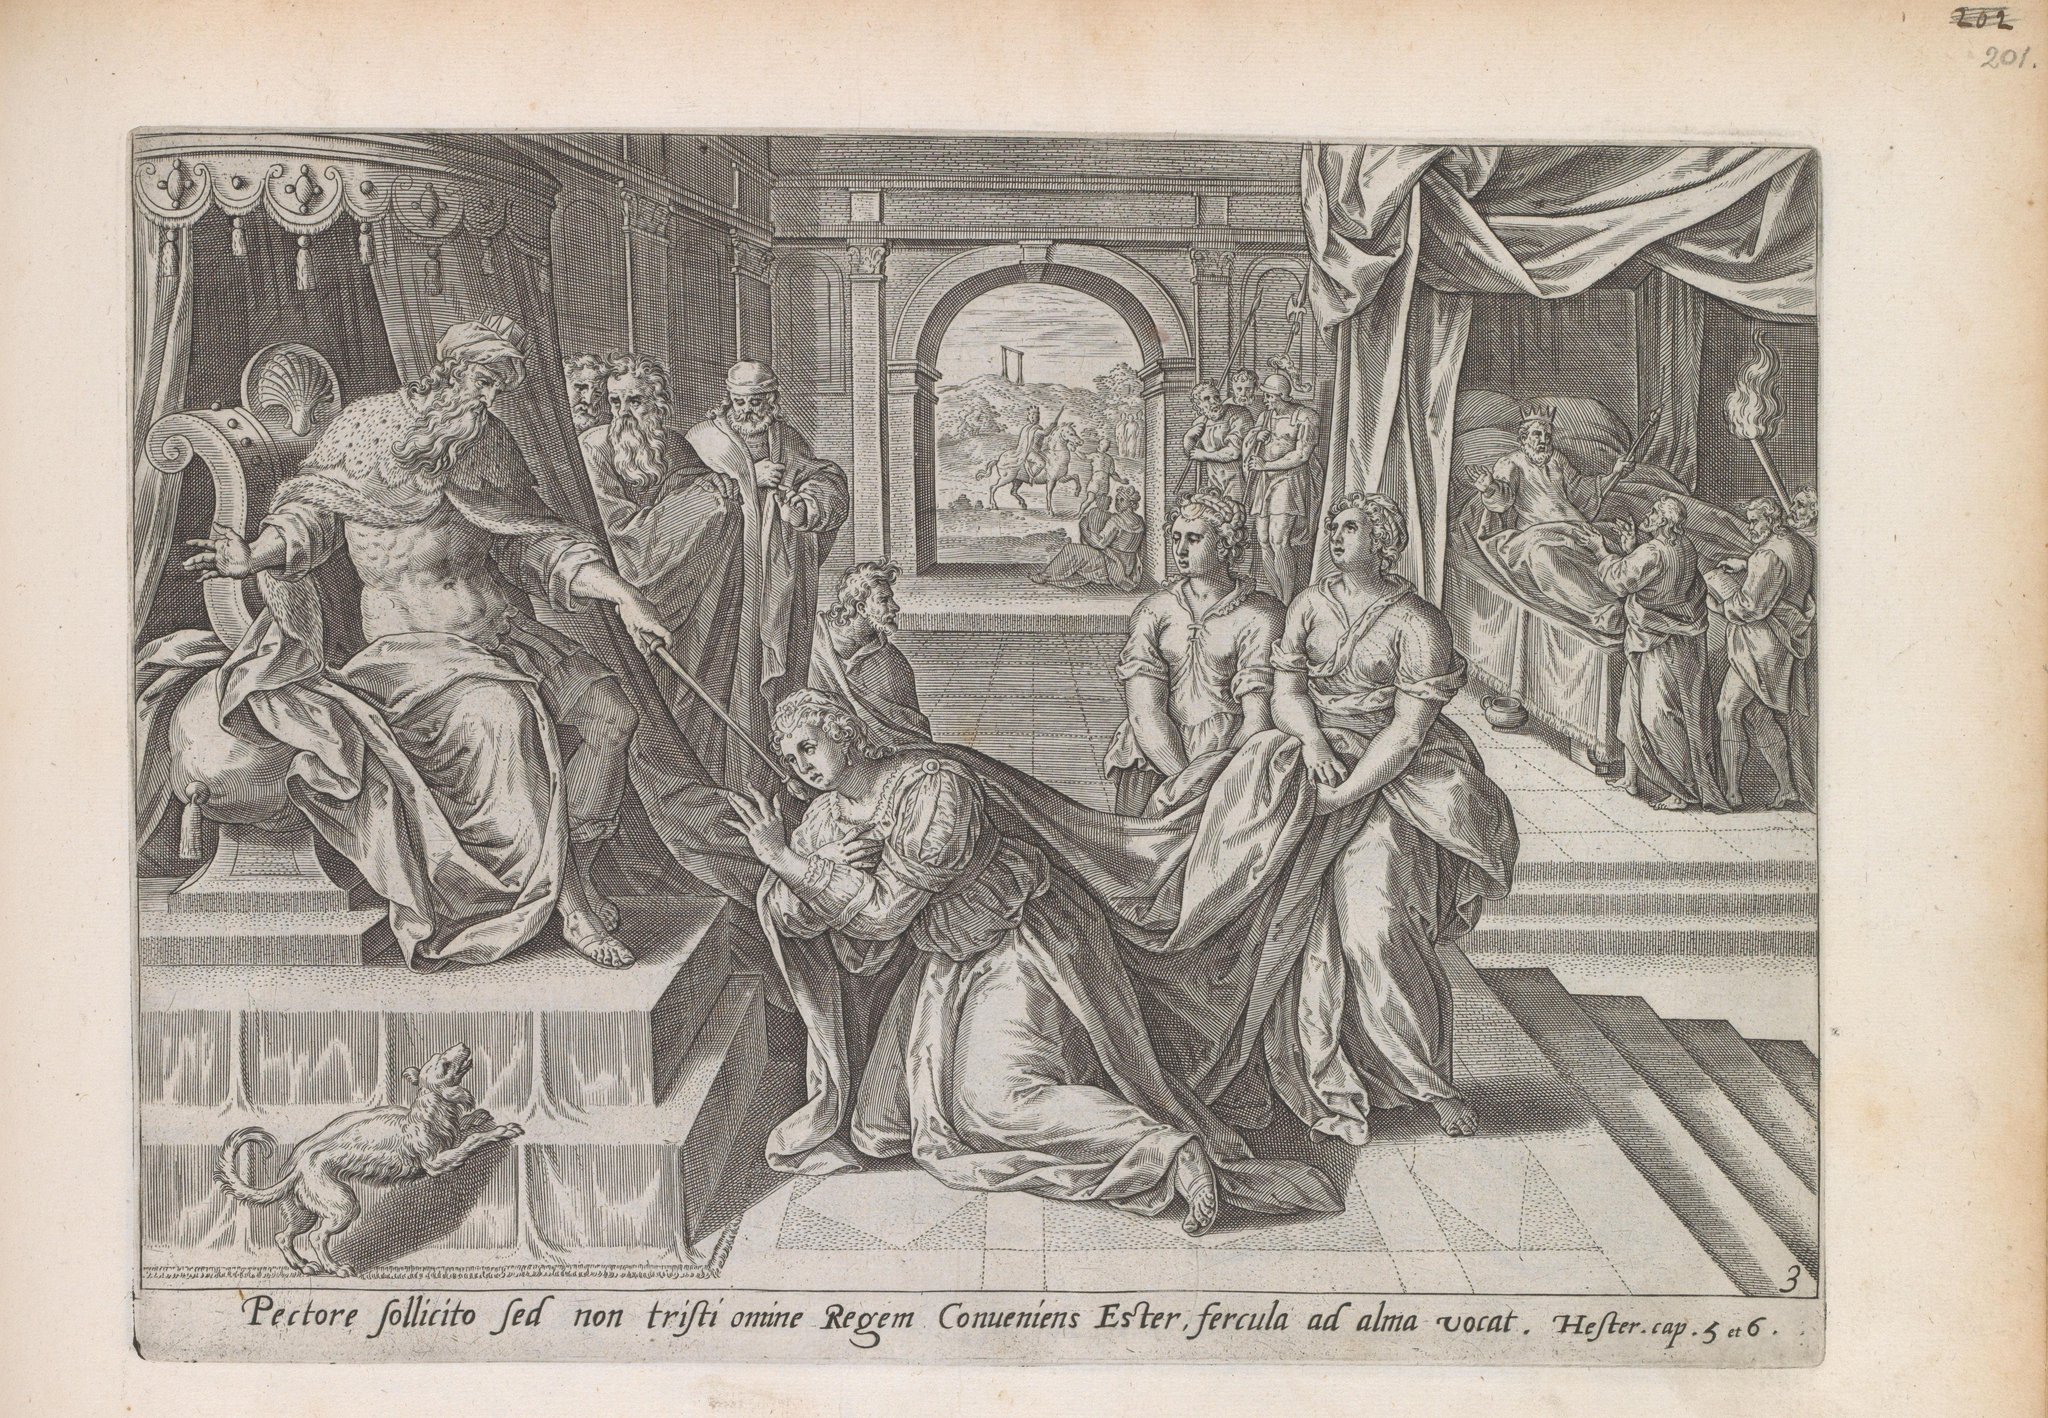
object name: album leaf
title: Geschiedenis van Ester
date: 1579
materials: paper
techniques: engraving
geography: amsterdam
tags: mordecai's triumph: mordecai, mounted on the king's horse, is led through the city by haman (esther and ahasuerus may be looking on from the palace), ahasuerus holds out his sceptre to esther (esther usually kneeling), ahasuerus being sleepless, has the court records read to him, king ahasuerus asks haman how to honour a man he wishes to reward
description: Ester knielt voor koning Ahasveros. De koning wijst zijn scepter naar haar als teken van genegenheid. Ester verzoekt de koning om samen met Haman naar het door haar verzorgde feestmaal te komen. Rechts op de achtergrond het vervolg van het verhaal. De koning laat zich 's avonds voorlezen uit de kronieken van het rijk. Daarin staat dat Mordechai een aanslag op het leven van de koning heeft verijdeld. De koning vraagt aan Haman, die bij het bed staat, hoe iemand die het leven van de koning heeft gered geëerd moet worden. Op de achtergrond is te zien hoe Mordechai in het kleed van en op het paard van de koning wordt rondgereden, terwijl Haman hem rondleidt. Onder de voorstelling een verwijzing in het Latijn naar de Bijbeltekst in Est. 5-6. Deze prent maakt deel uit van een album.